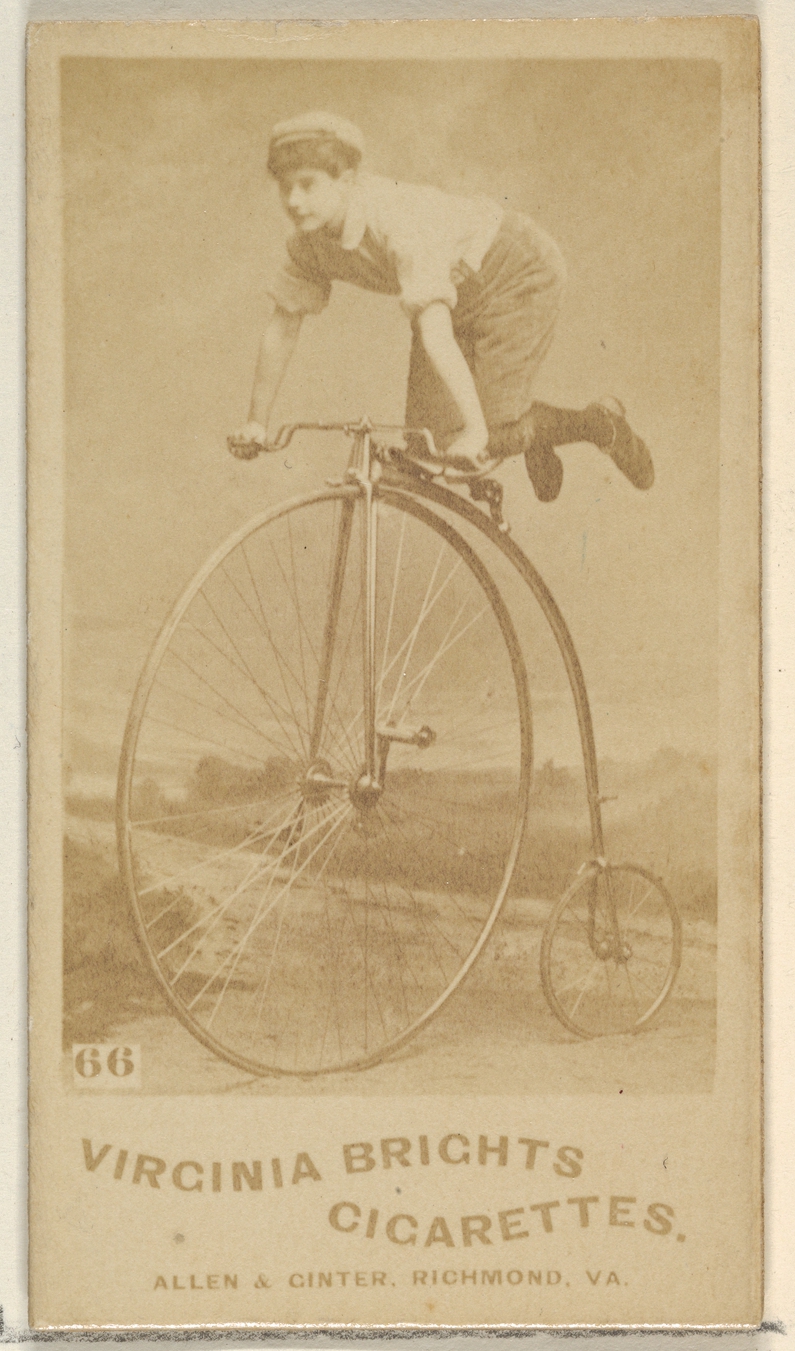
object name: photograph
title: Card 66, from the Girl Cyclists series (N49) for Virginia Brights Cigarettes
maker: allen & ginter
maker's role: publisher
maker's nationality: american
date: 1887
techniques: albumen silver print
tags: girls,bicycles